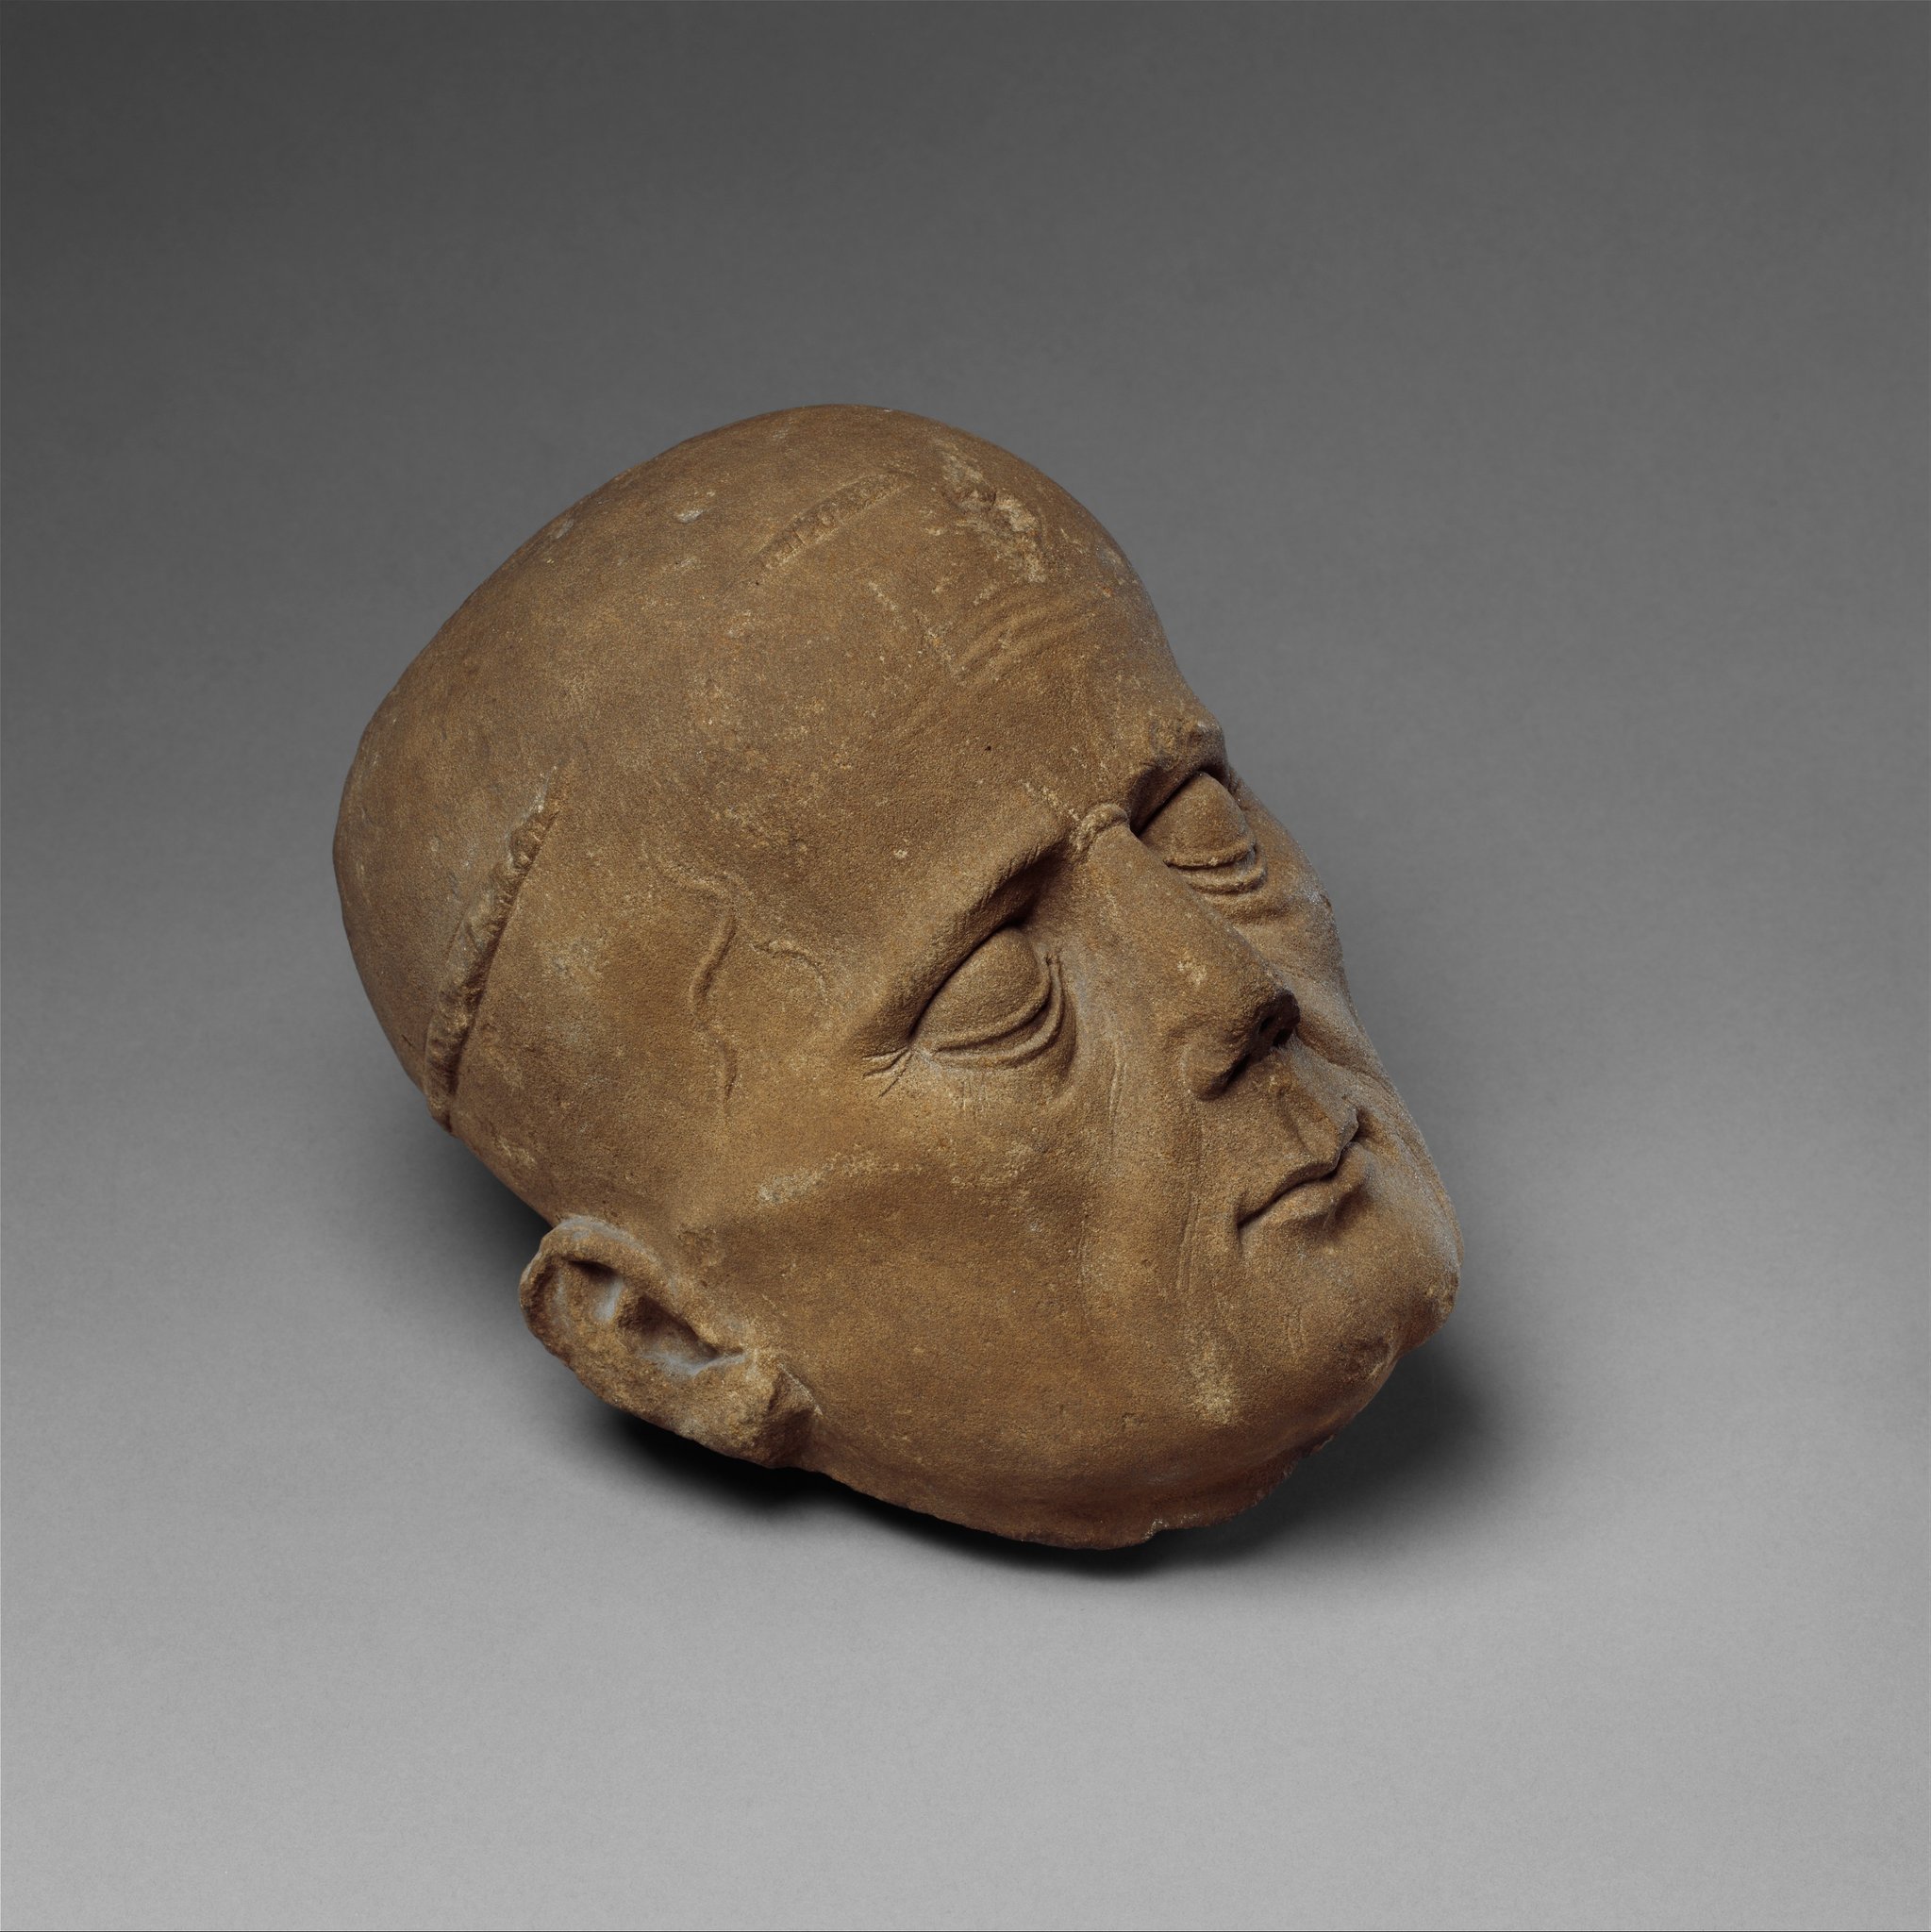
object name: statue head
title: Head of a Cleric from a Tomb Effigy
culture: french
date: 1450-1460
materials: stone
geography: france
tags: heads,men